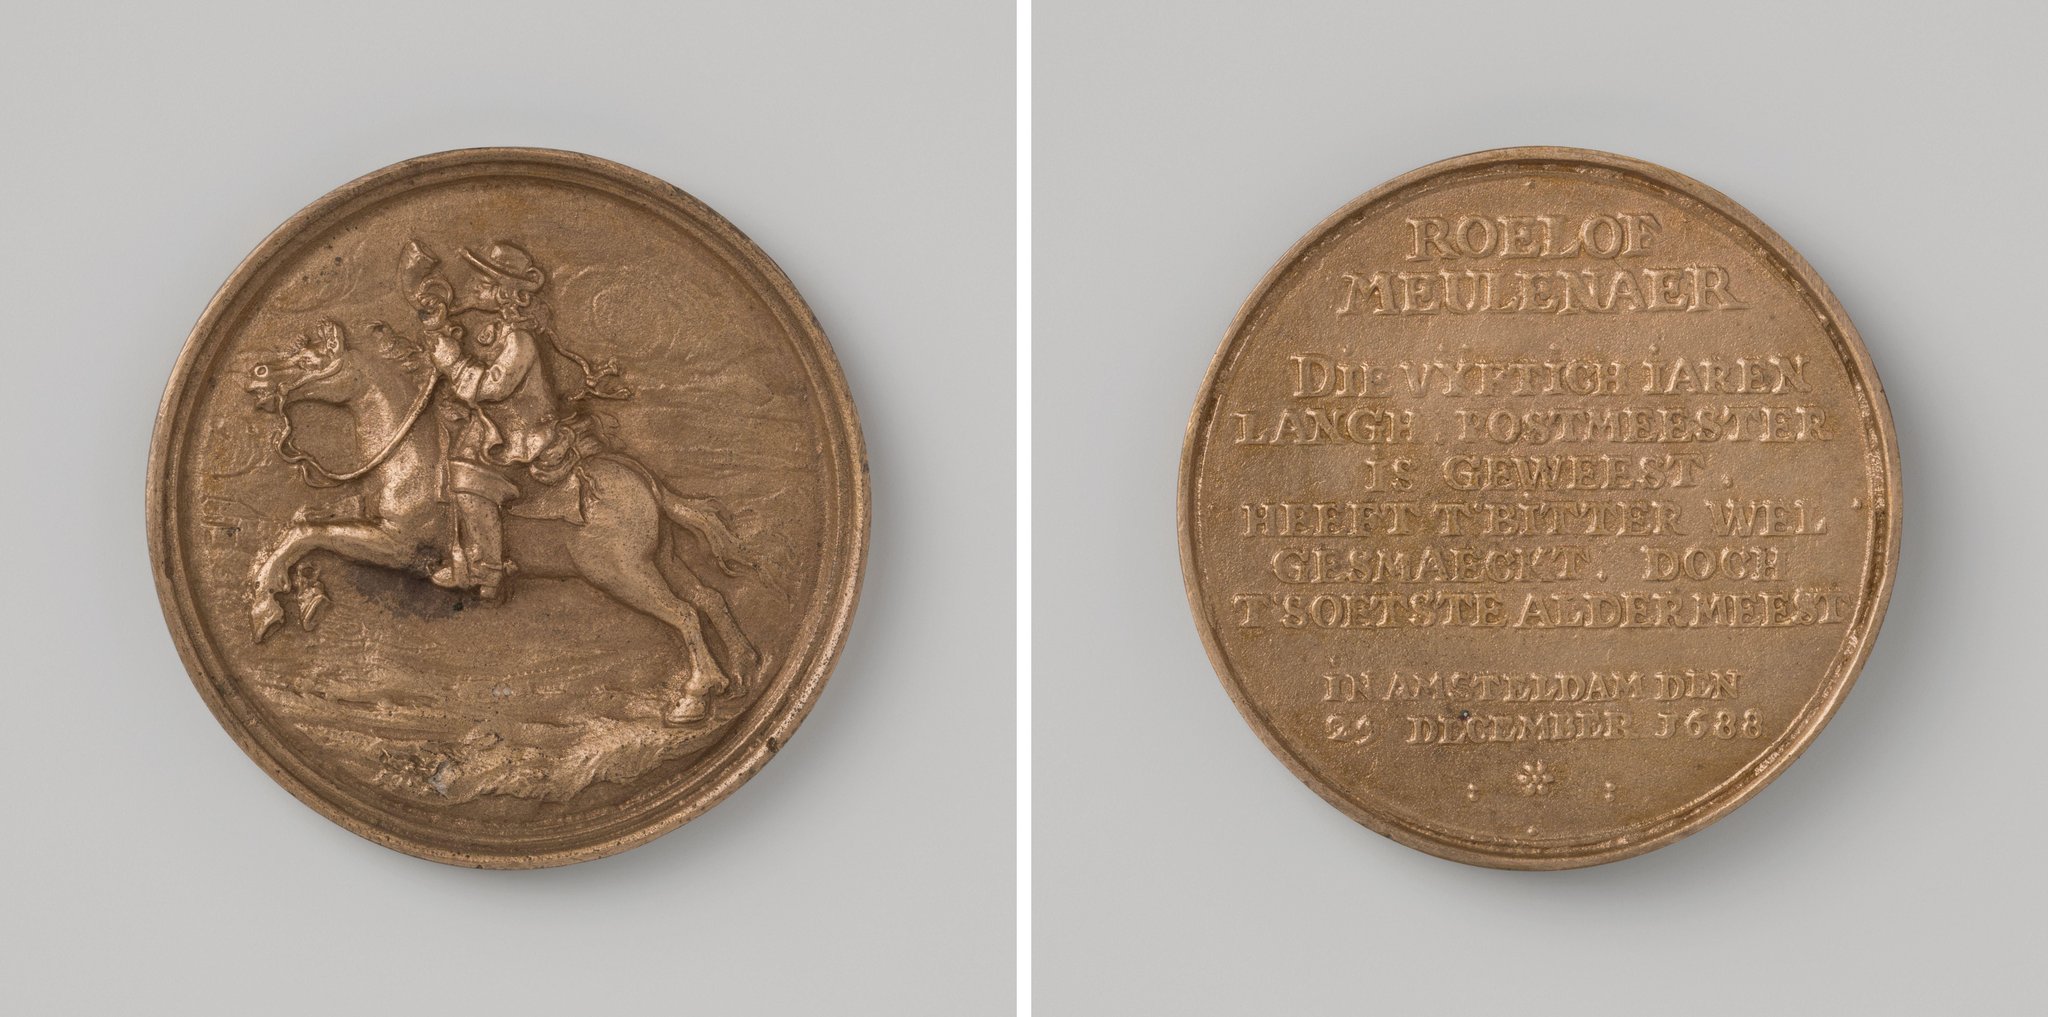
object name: history medal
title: Vijftigjarig postmeesterschap van Roelof Meulenaer 1688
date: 1688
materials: brass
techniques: casting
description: Messing penning, op de voorzijde een postmeester met posthoorn te paard naar links, op de keerzijde tien regels tekst boven een rozet.